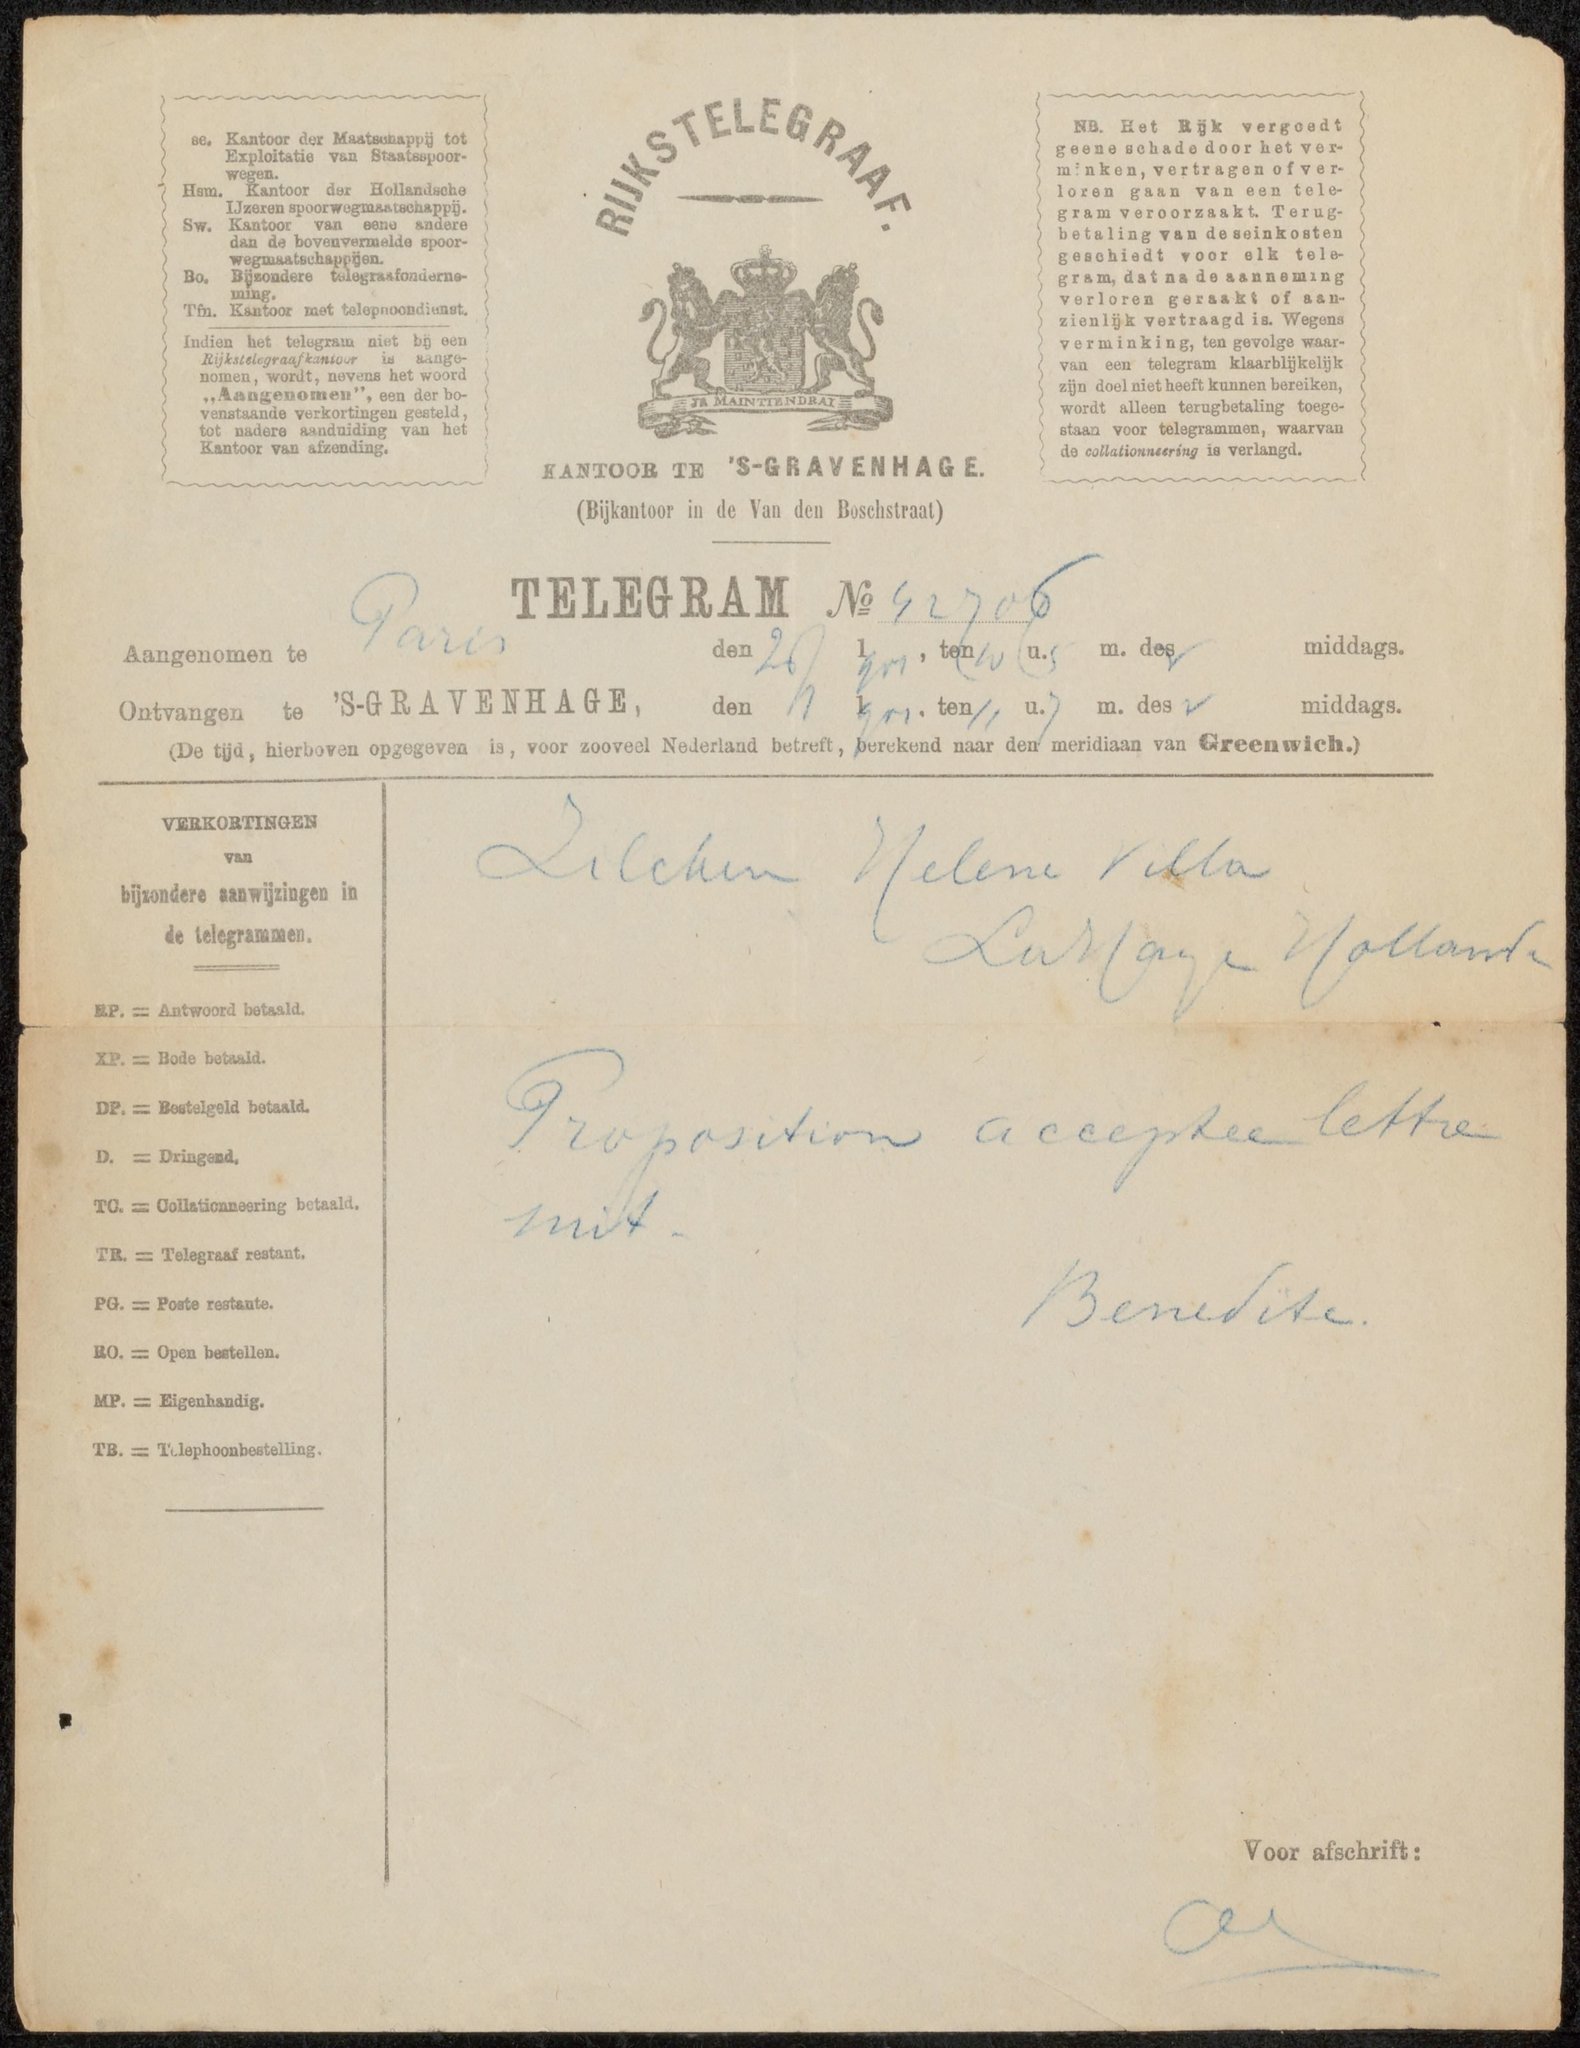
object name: telegram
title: Telegram aan Philip Zilcken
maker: léonce bénédite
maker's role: conservator, museumdirecteur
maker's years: 1856-1925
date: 1901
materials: paper, pencil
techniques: printing, writing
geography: paris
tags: the hague, painter, draughtsman, philip zilcken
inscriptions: collector's mark: ‘RPK’